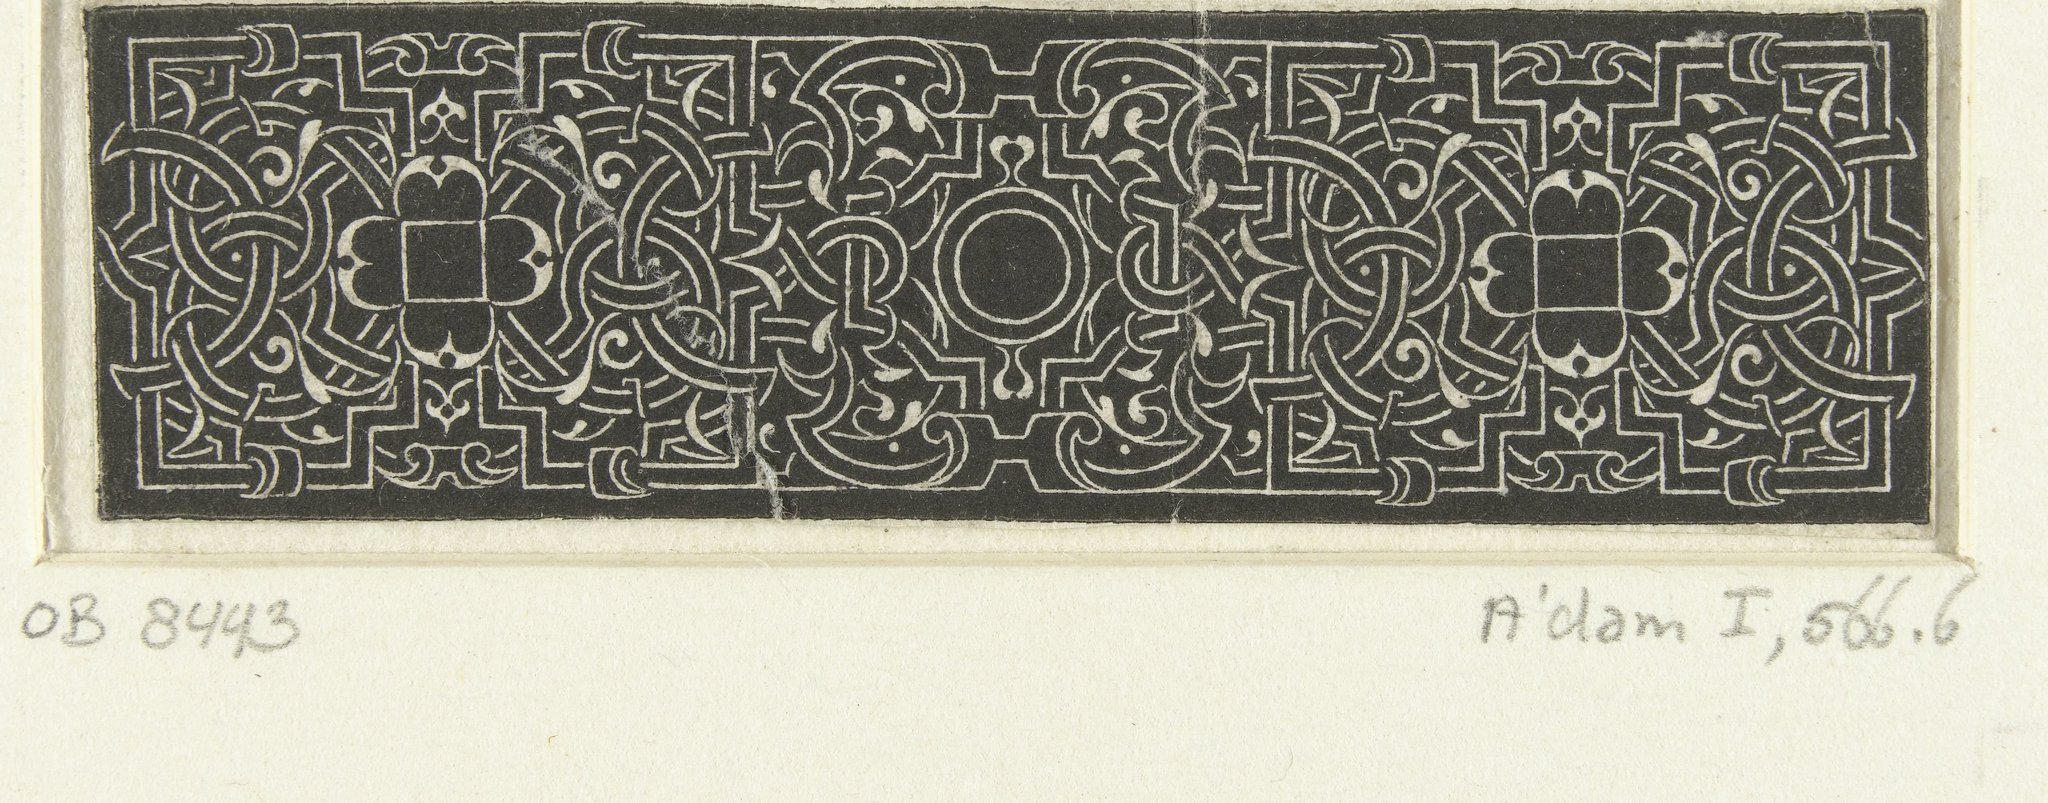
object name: ornament print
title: Fries met moresken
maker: Anonymous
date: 1506-1551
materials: paper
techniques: woodcut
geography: france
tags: mirror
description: In het midden is een cirkeltje uitgespaard, links en rechts daarvan een vierpas. Uit serie van 9 bladen?